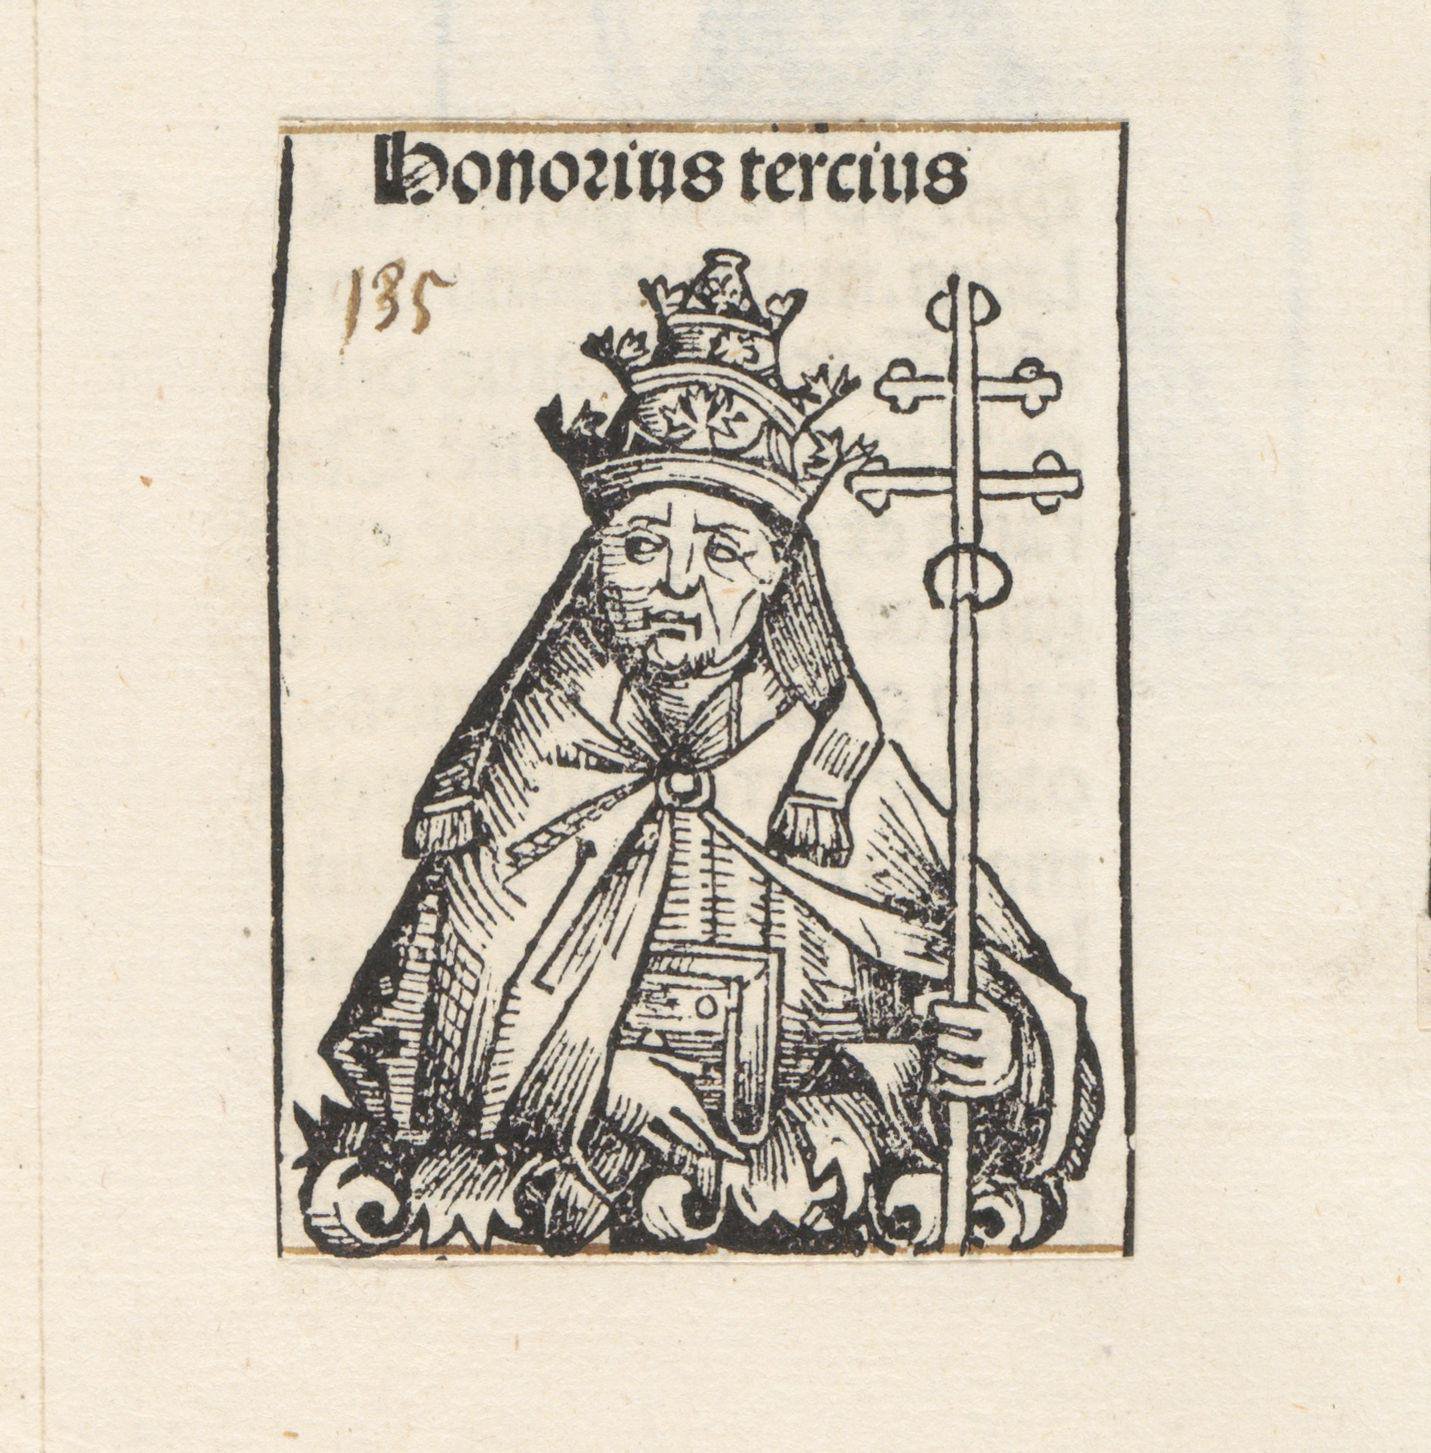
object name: album leaf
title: Honorius tercius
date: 1493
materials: paper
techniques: letterpress printing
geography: nuremberg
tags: pope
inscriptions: inscription: ‘135’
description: Een bloemkelk met een paus. Hij draagt een tiara en heeft een boek en een staf met dubbel kruis in zijn handen. De voorstelling is onderdeel van de opeenvolging pausen in de Liber Chronicarum. De tekst identificeert de man als Honorius III. De prent maakt deel uit van een album.